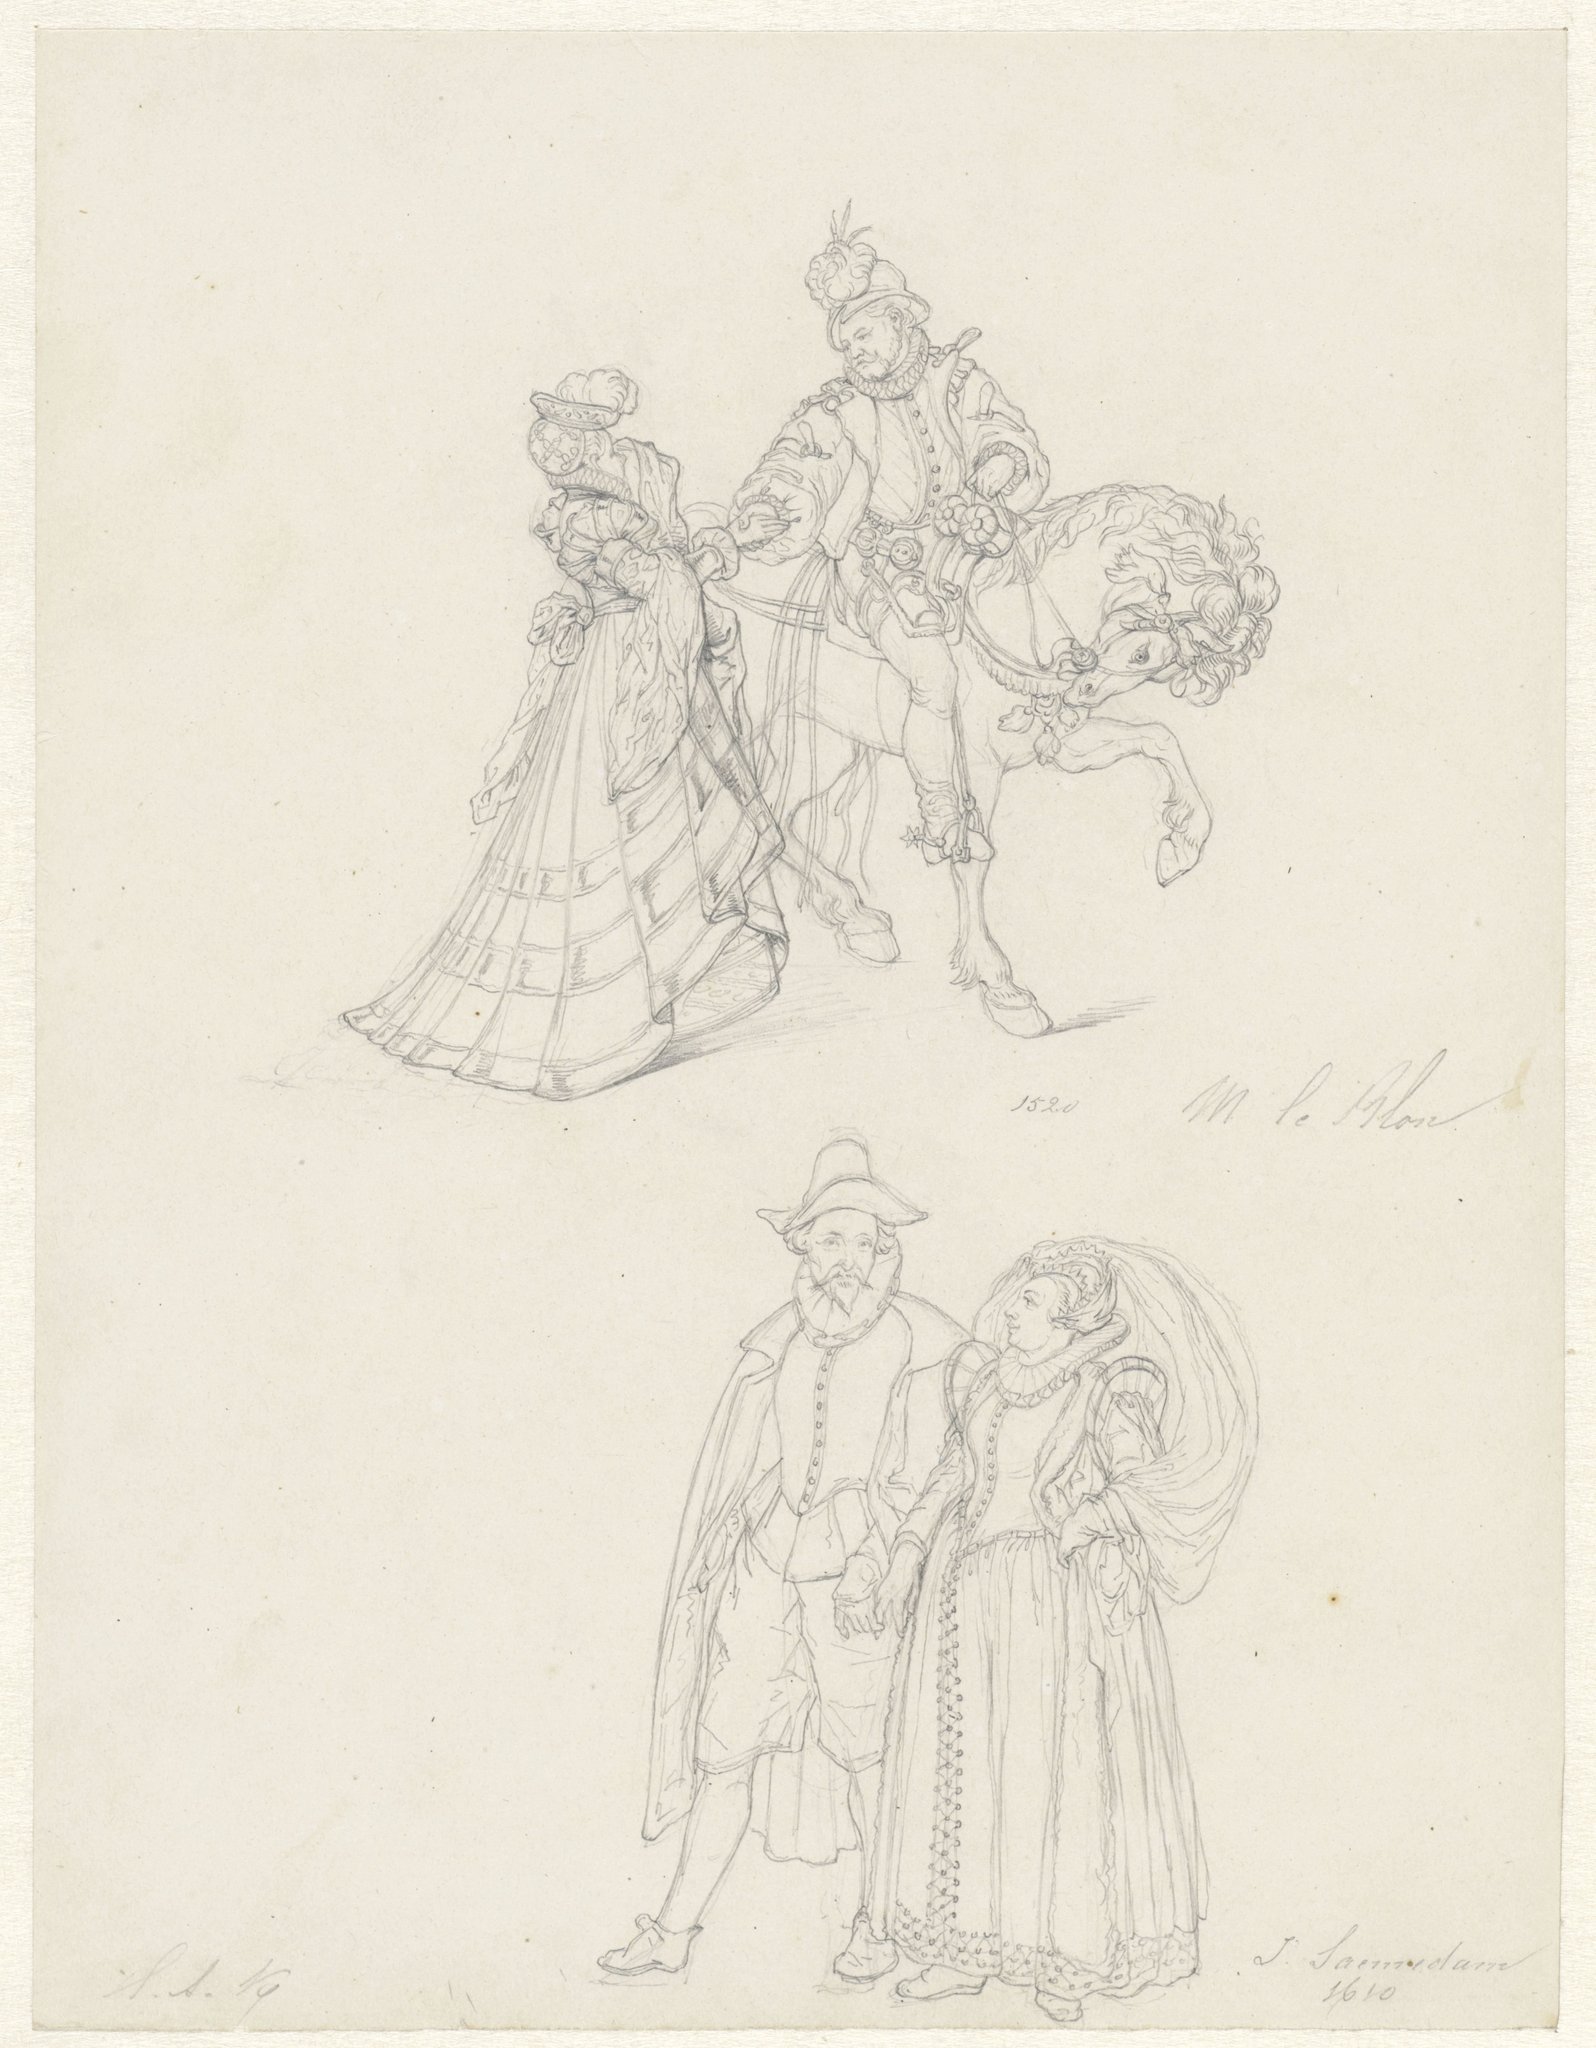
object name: schetsblad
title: Boven een man te paard, onder een man en een vrouw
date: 1820-1872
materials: paper, pencil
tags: female sex; woman, horse, male sex; man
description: Boven een man te paard, die afscheid neemt van een dame en onder een man en een vrouw, die gearmd lopen.